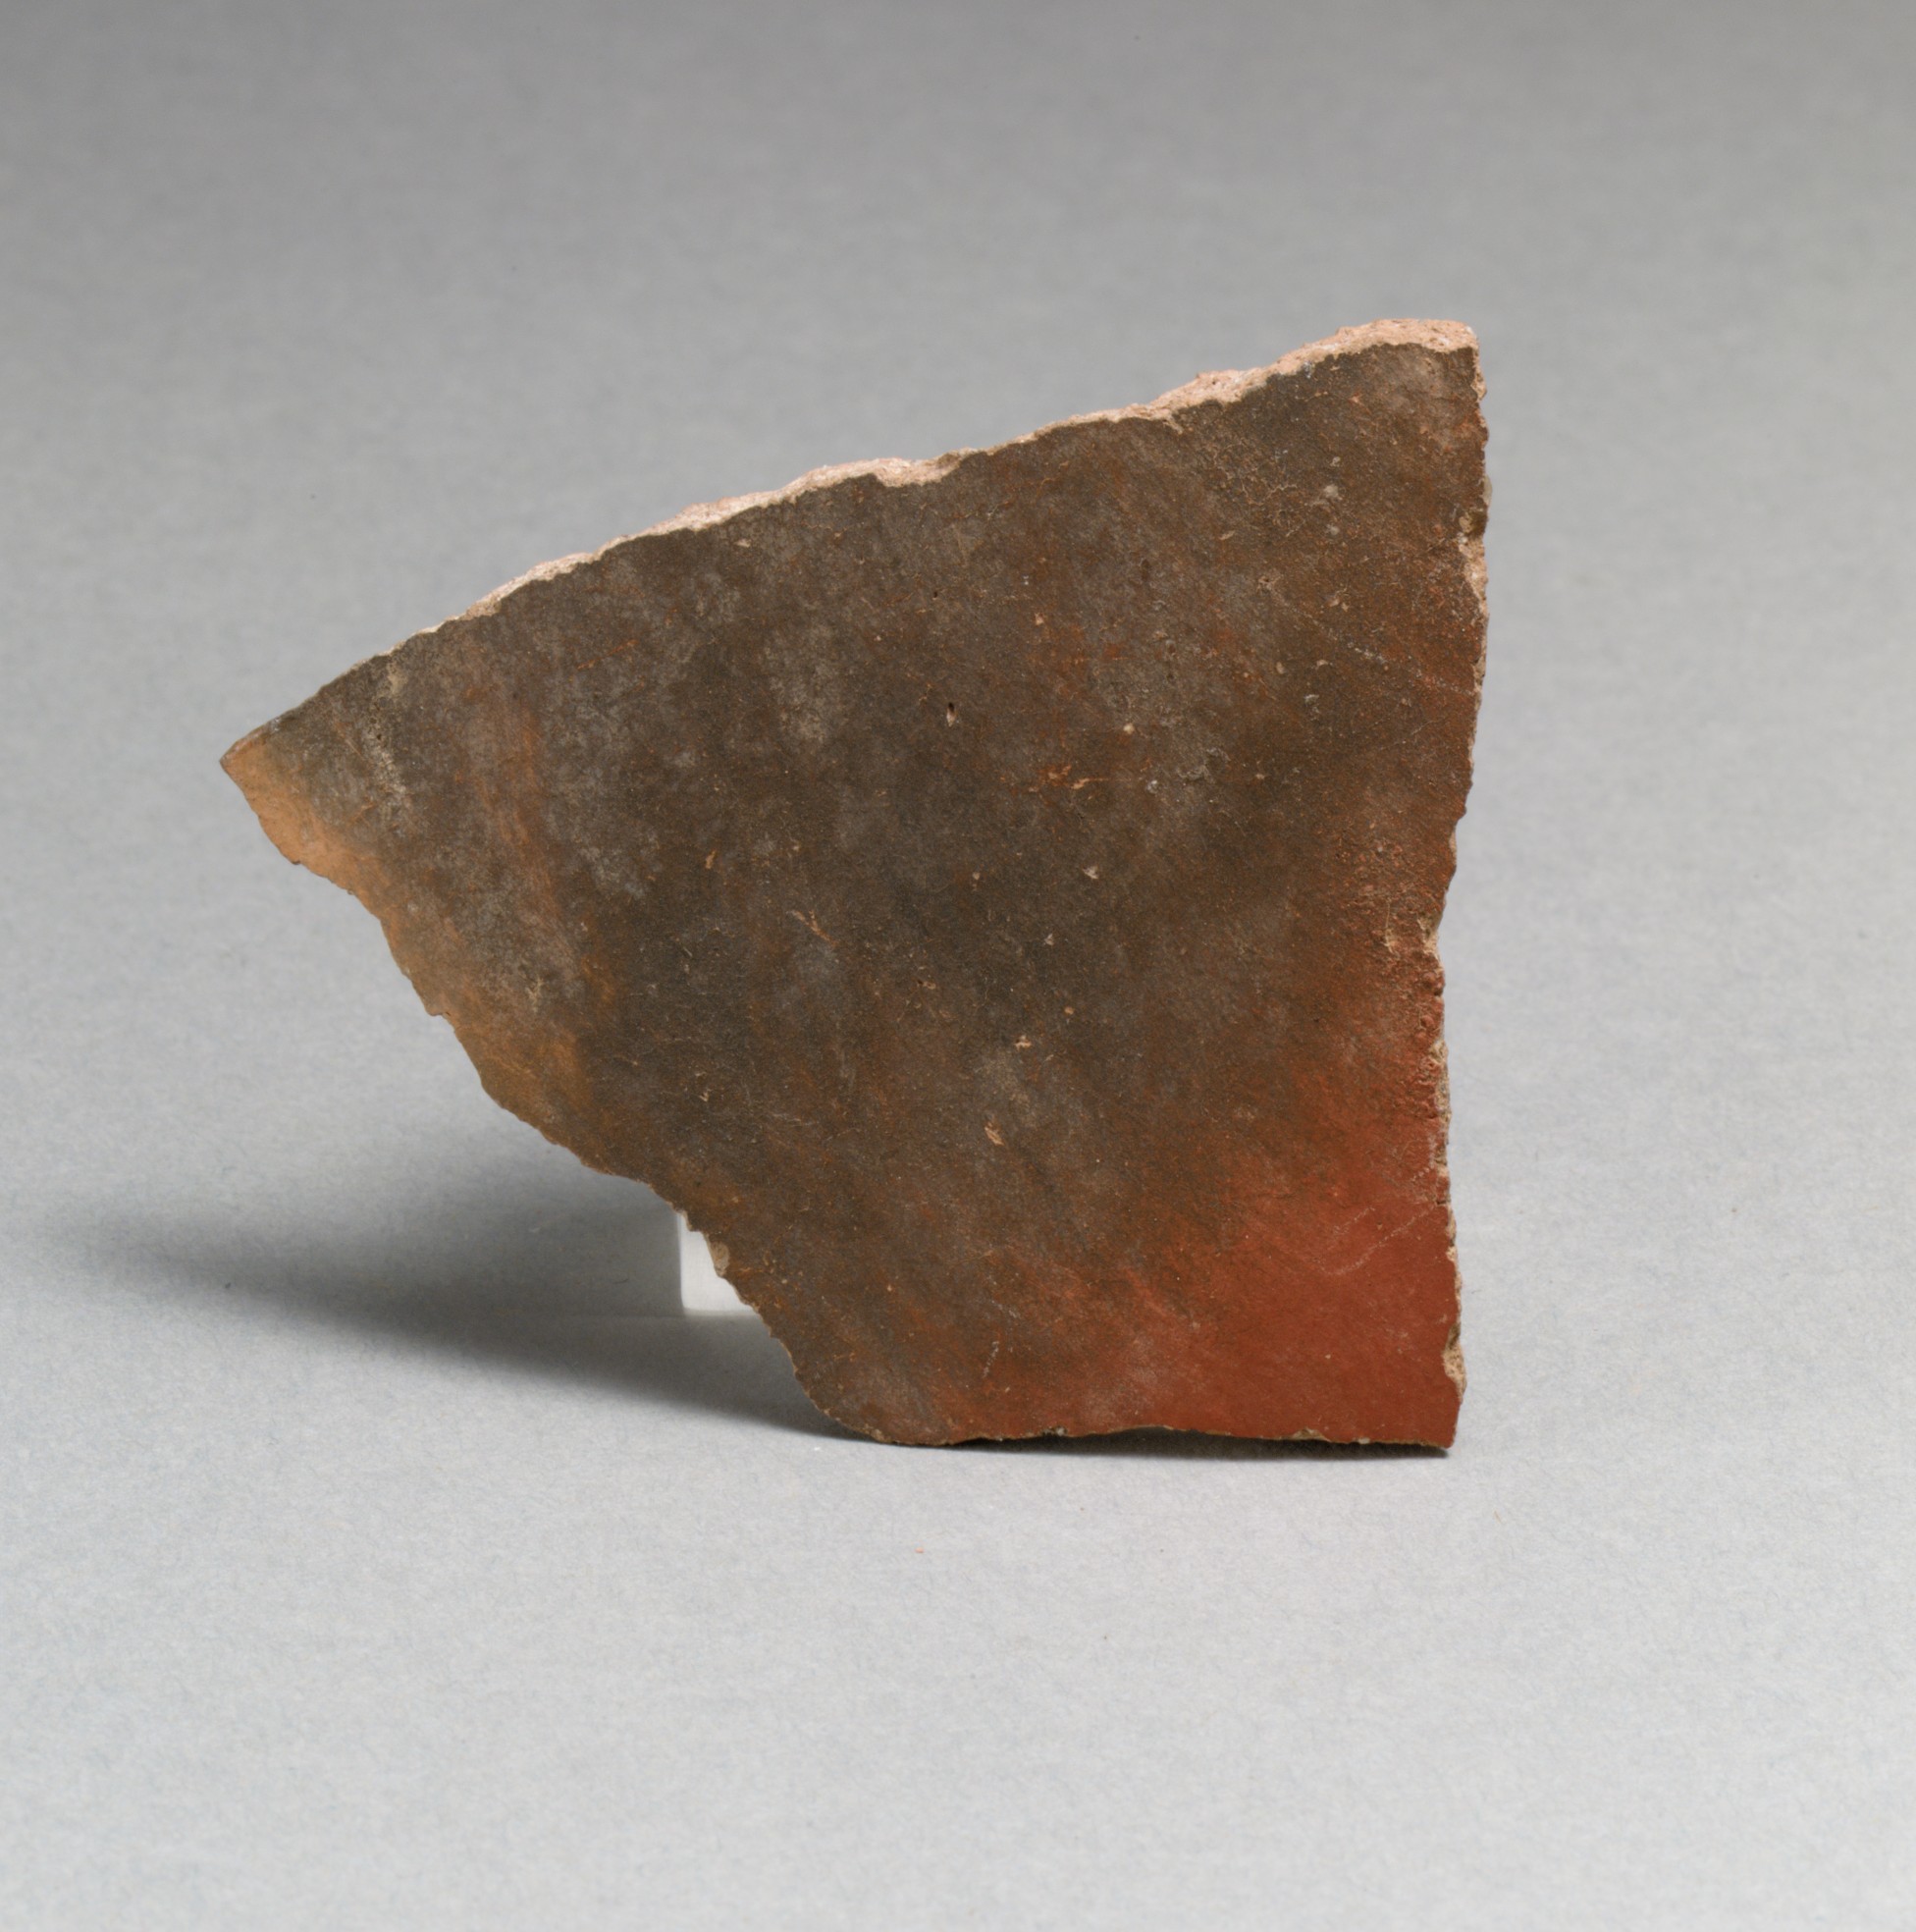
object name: vase fragment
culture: minoan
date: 2600-2000 BCE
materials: terracotta